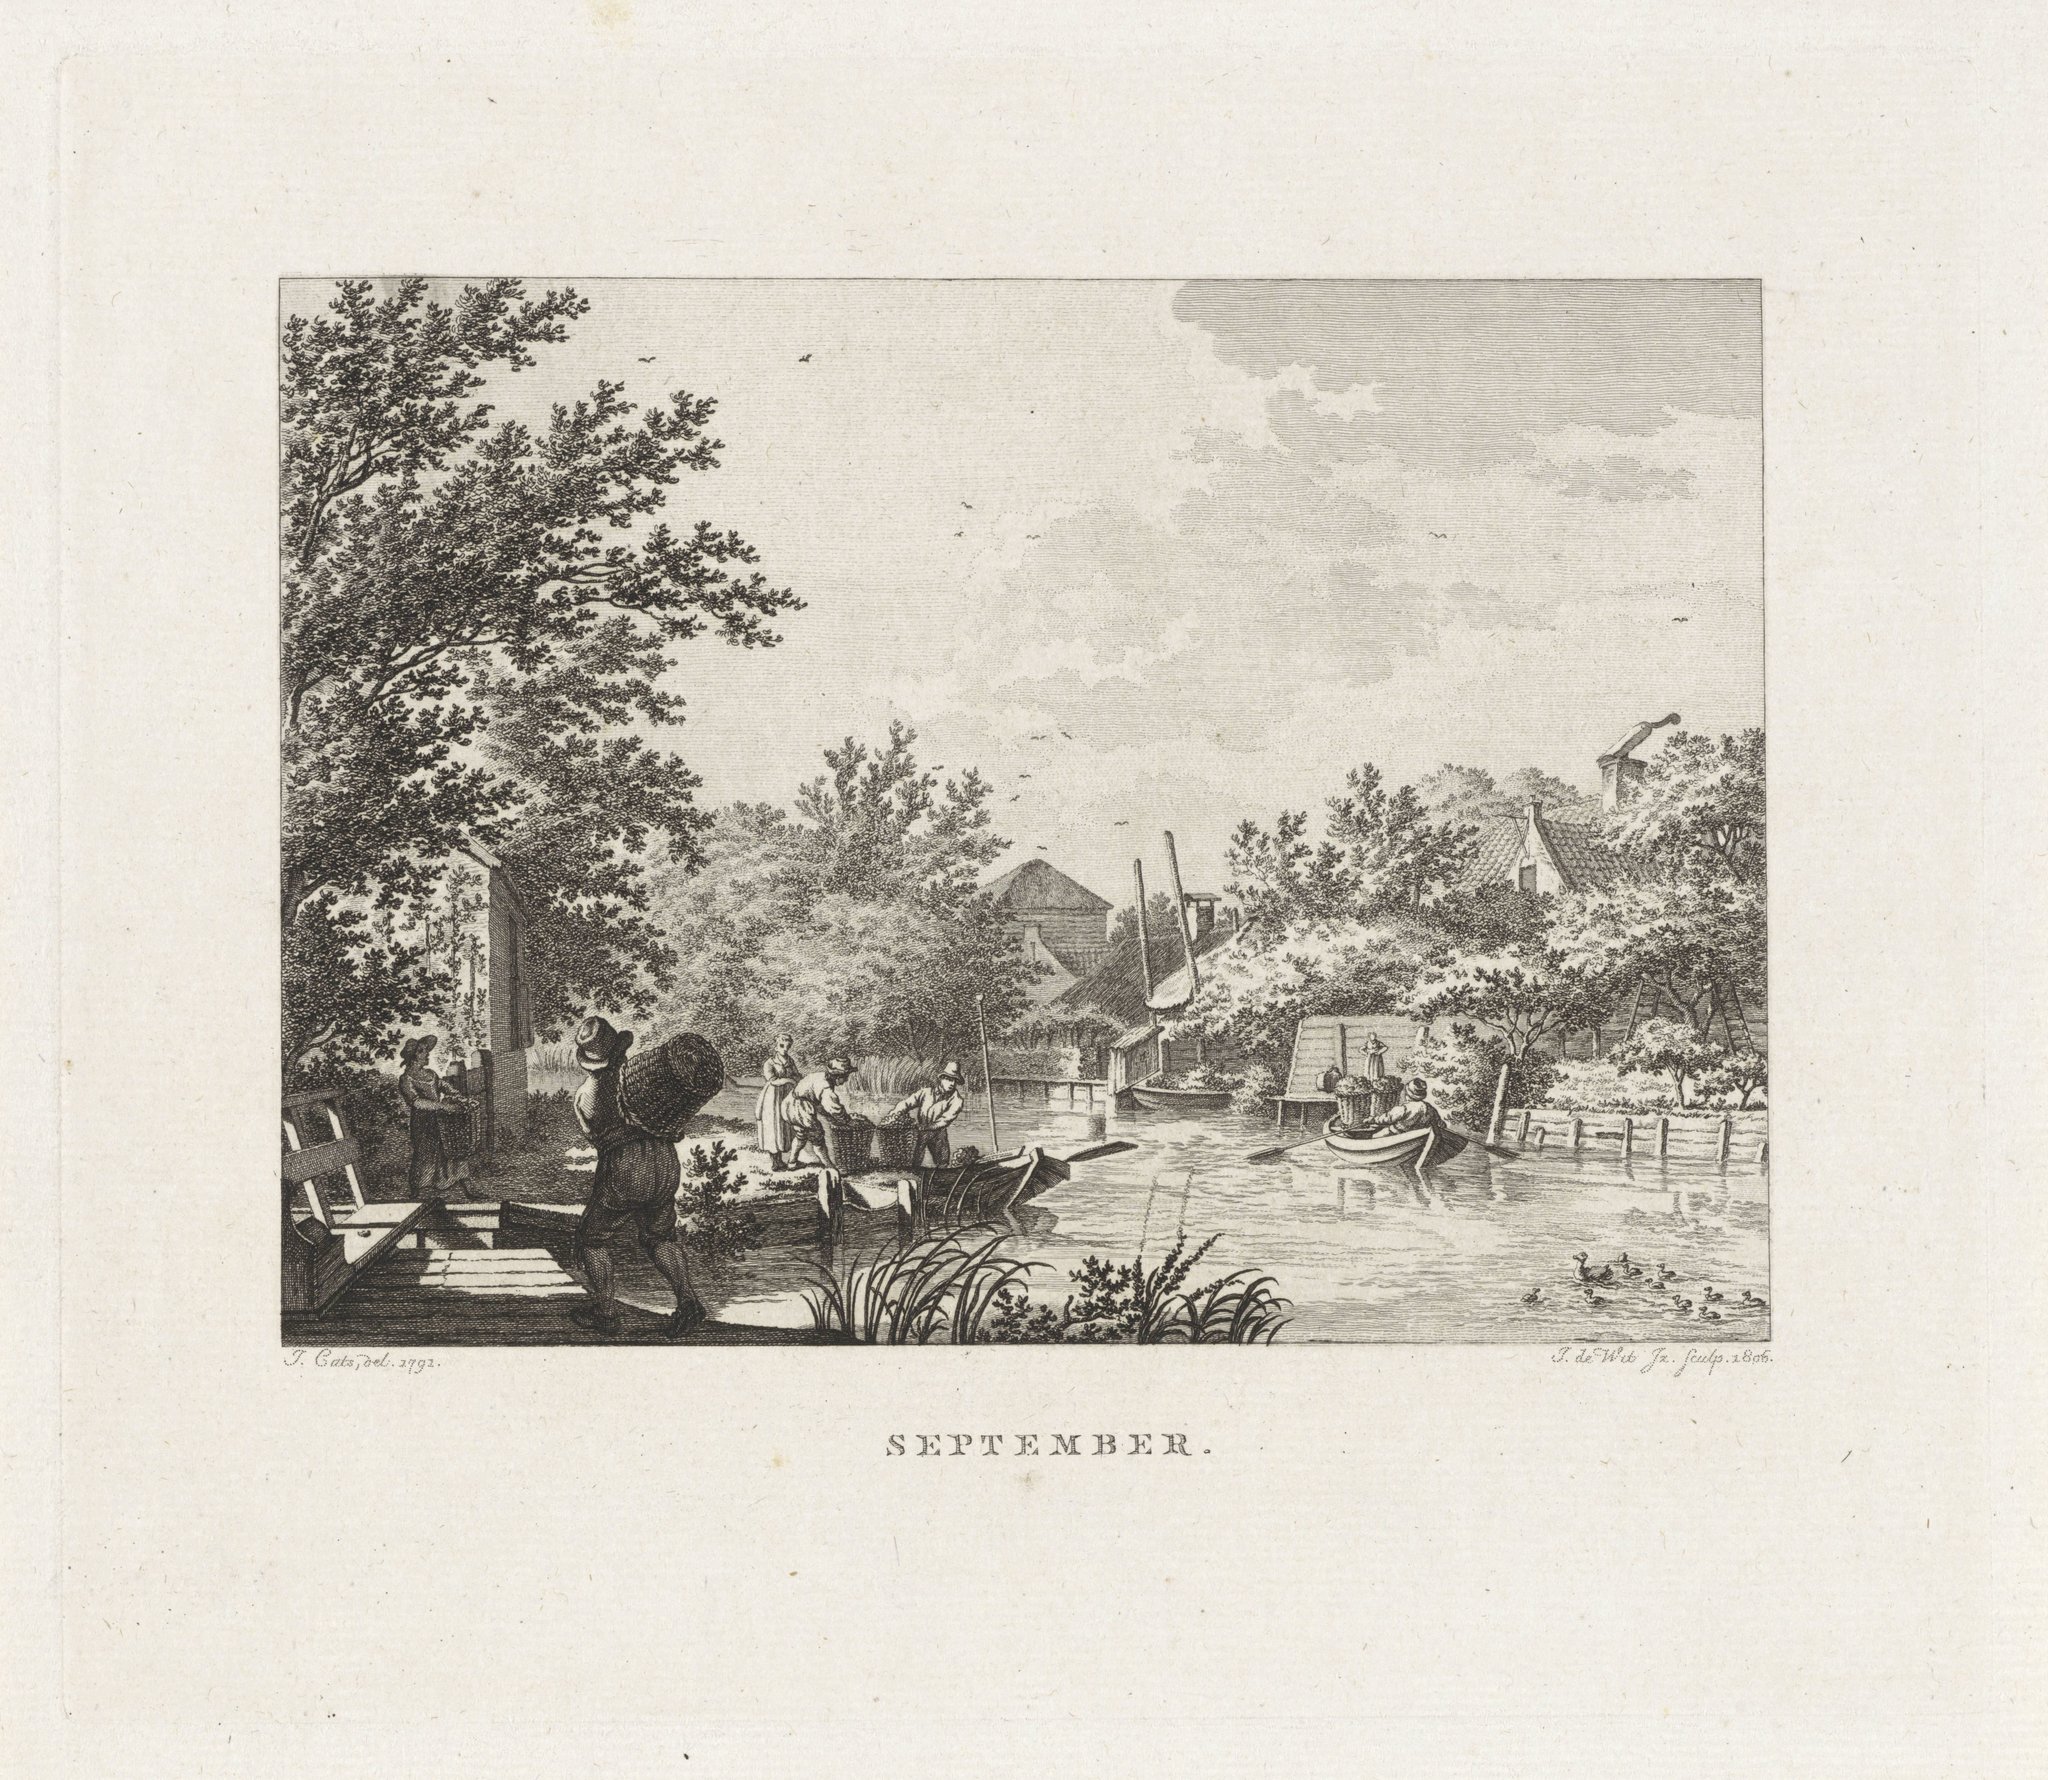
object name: print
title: De twaalf maanden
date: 1806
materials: paper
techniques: etching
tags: september and its 'labours' (+ with scenes showing human occupations ~ seasons and months), carrying something in basket, bag, rucksack, etc., container made of plant material other than wood: basket, rowing-boat, canoe, etc., transporting ~ harvest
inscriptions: collector's mark: Lugt 2228